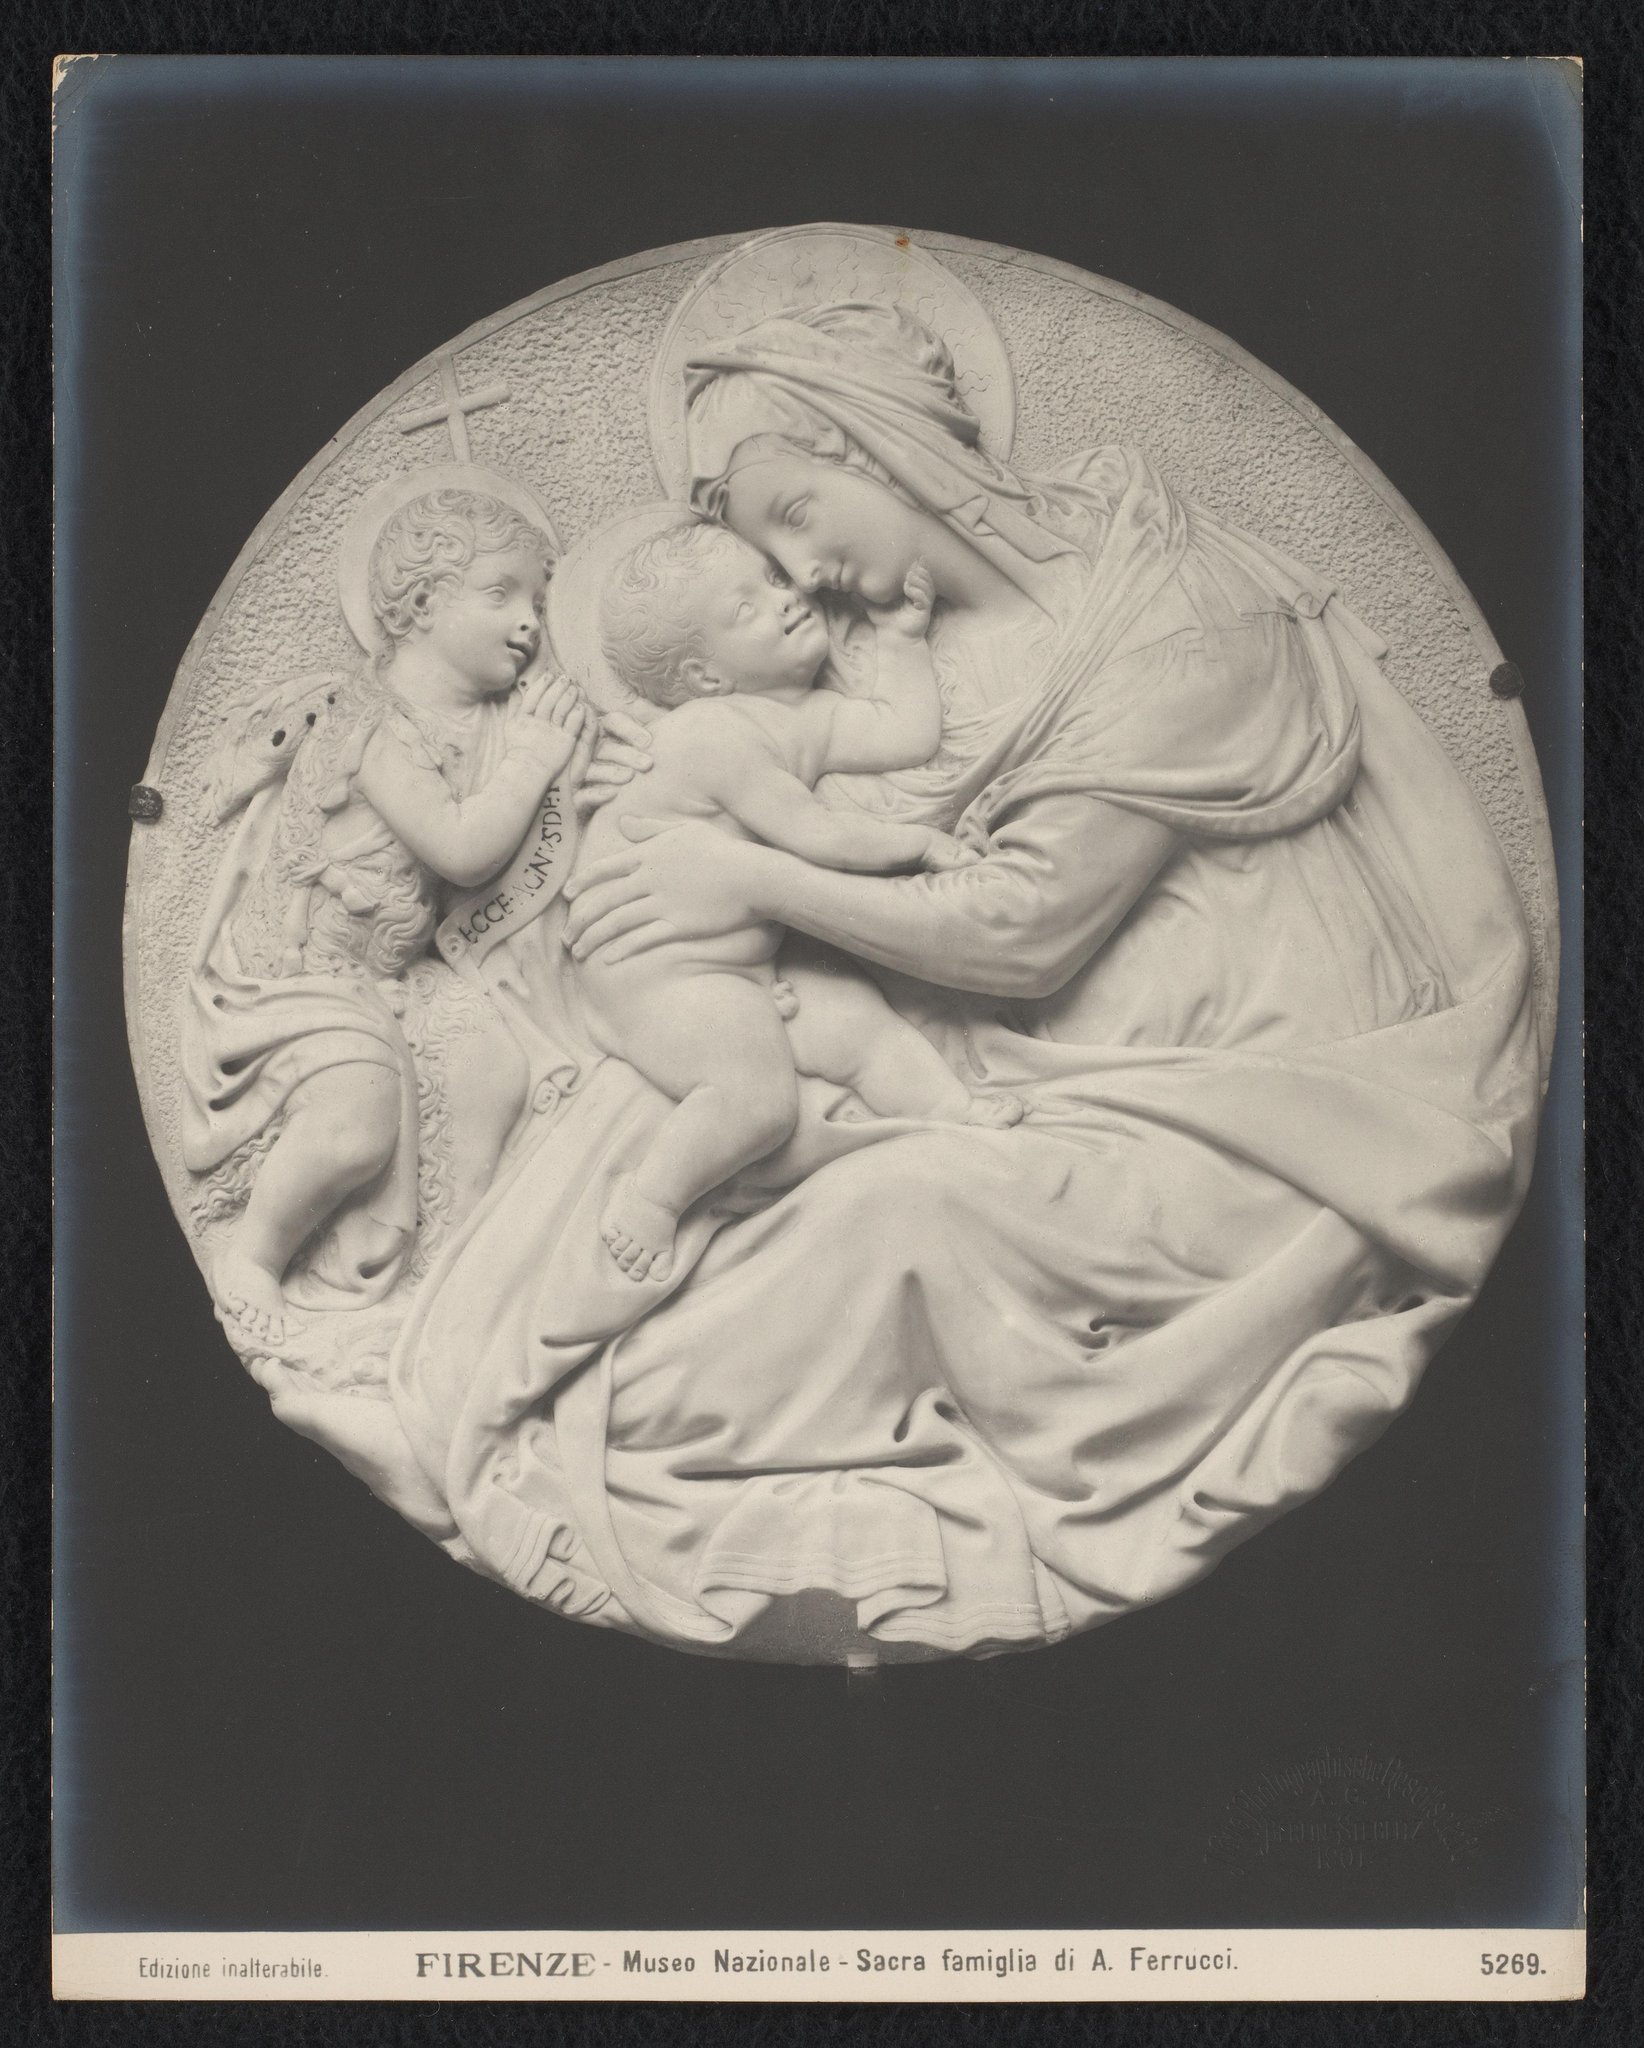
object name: photograph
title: Reliëf van de heilige familie door Andrea Ferrucci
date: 1901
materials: paper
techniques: gelatin silver print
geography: berlin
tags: picture, painting, sculpture (+ relief ~ sculpture)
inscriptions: collector's mark: ‘RIJKS SCHOOL VOOR KUNSTNIJVERHEID/ GROEP’, inscription: ‘Edizione inalterabile.’, number: ‘5269.’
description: Deze foto maakt deel uit van een omslag.